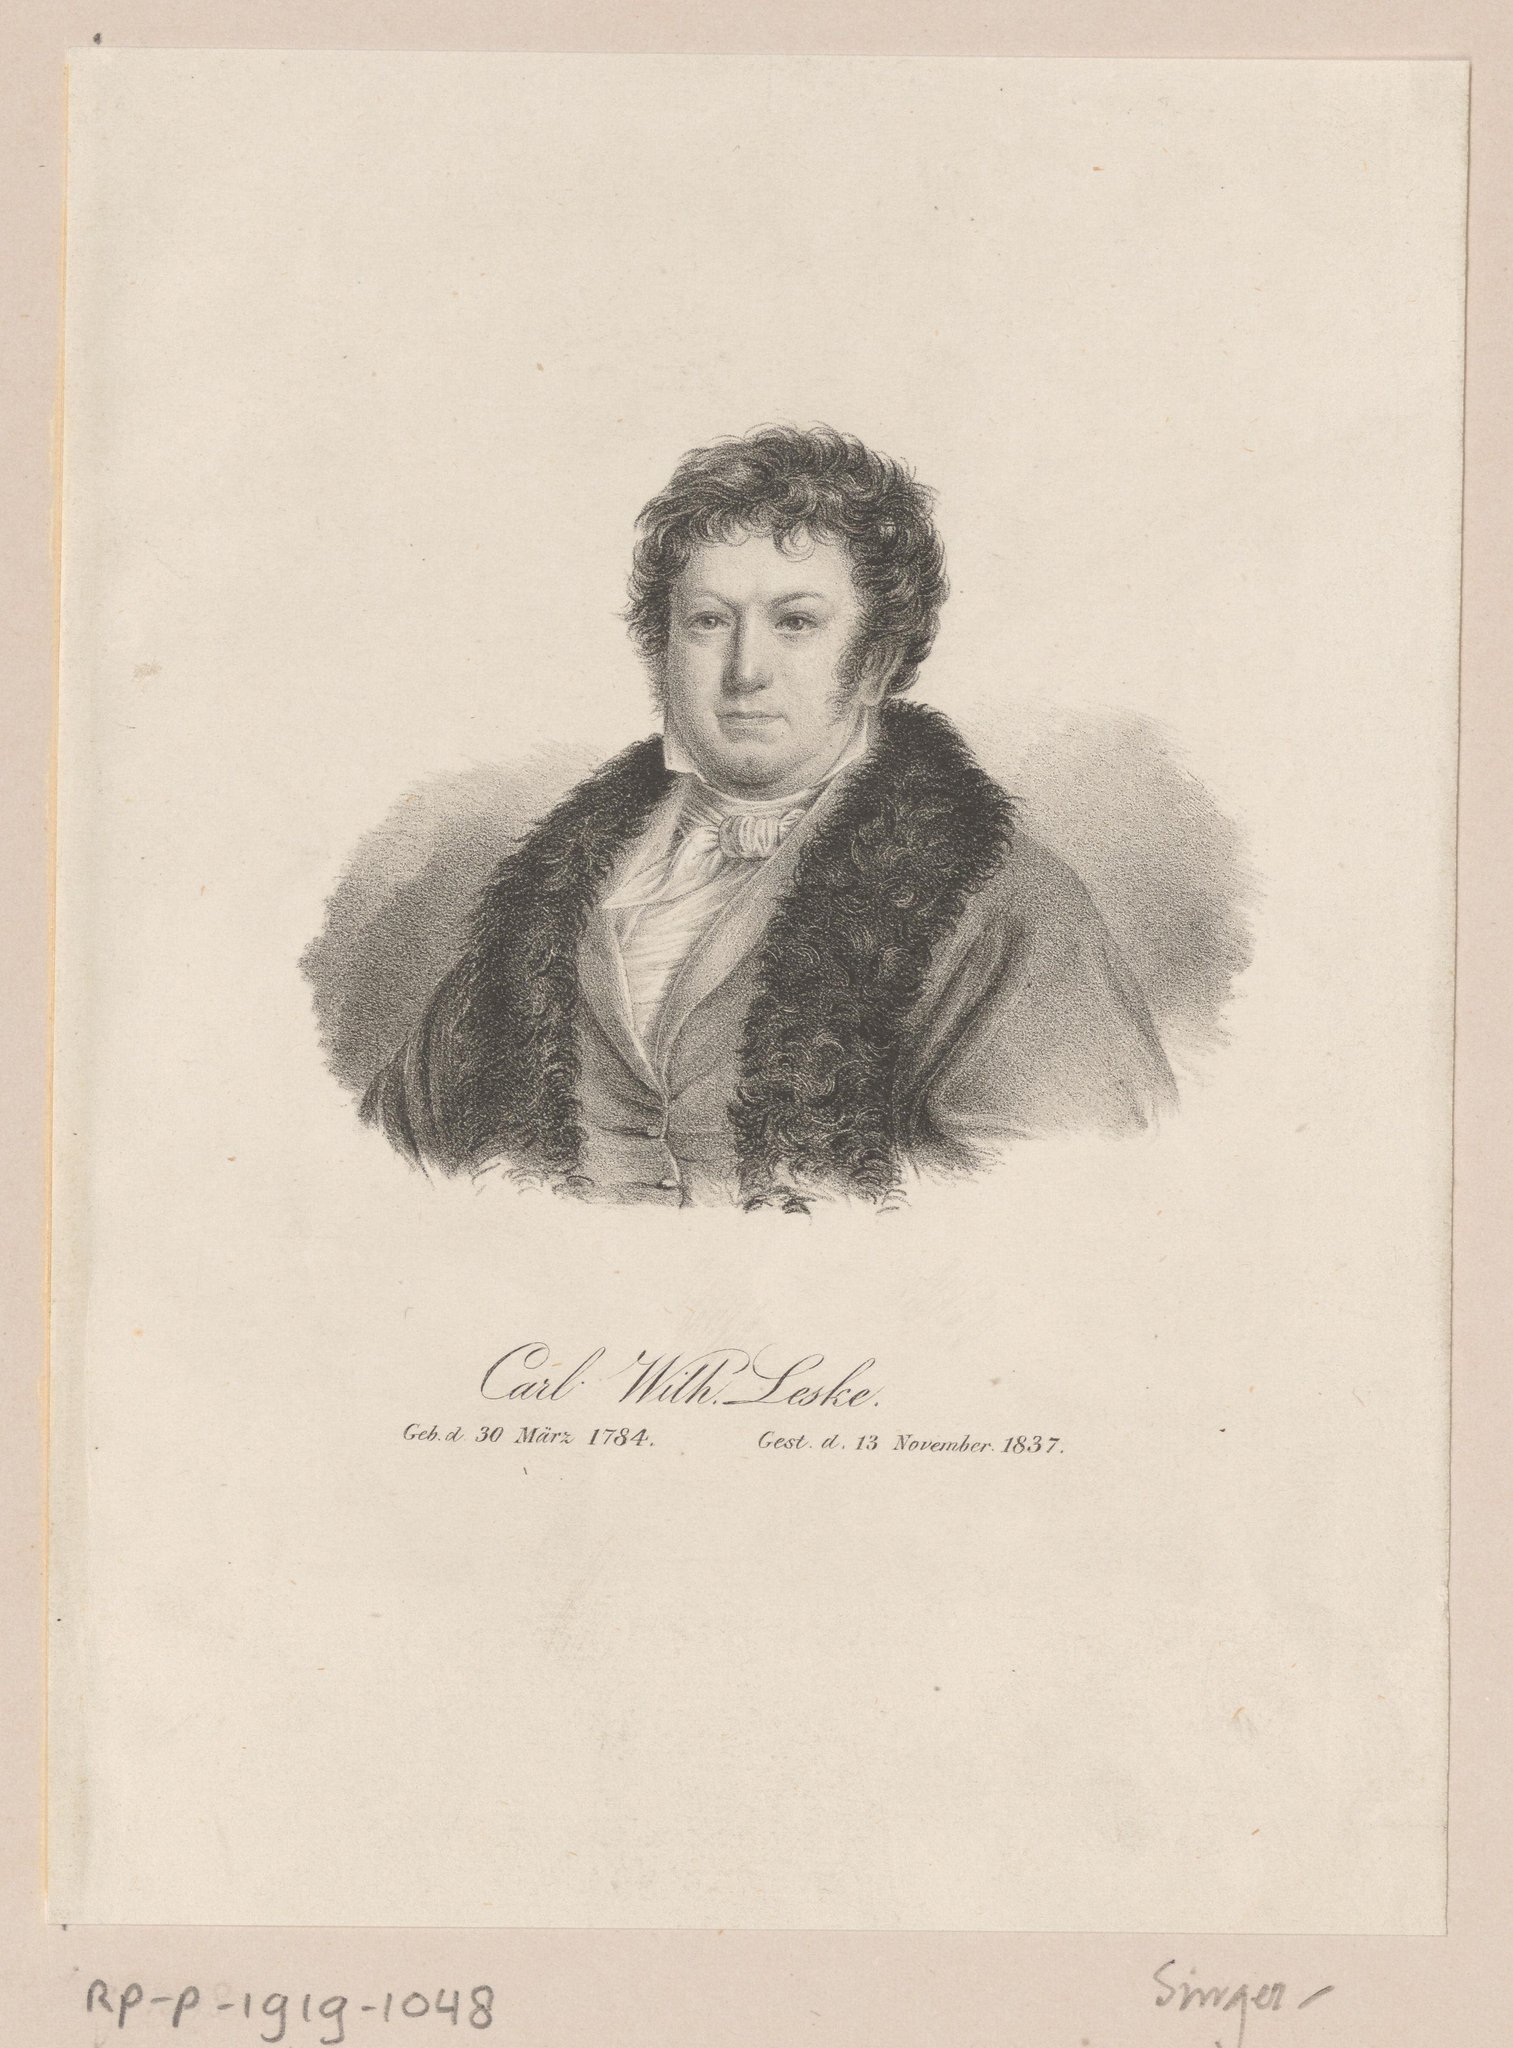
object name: print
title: Portret van Carl Wilhelm Leske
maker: Anonymous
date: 1837-1850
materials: paper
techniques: lithograph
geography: germany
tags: printer, publisher, carl wilhelm leske, publishing, publisher (+ portrait of scholar, scientist), historical persons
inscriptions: collector's mark: Lugt 2228